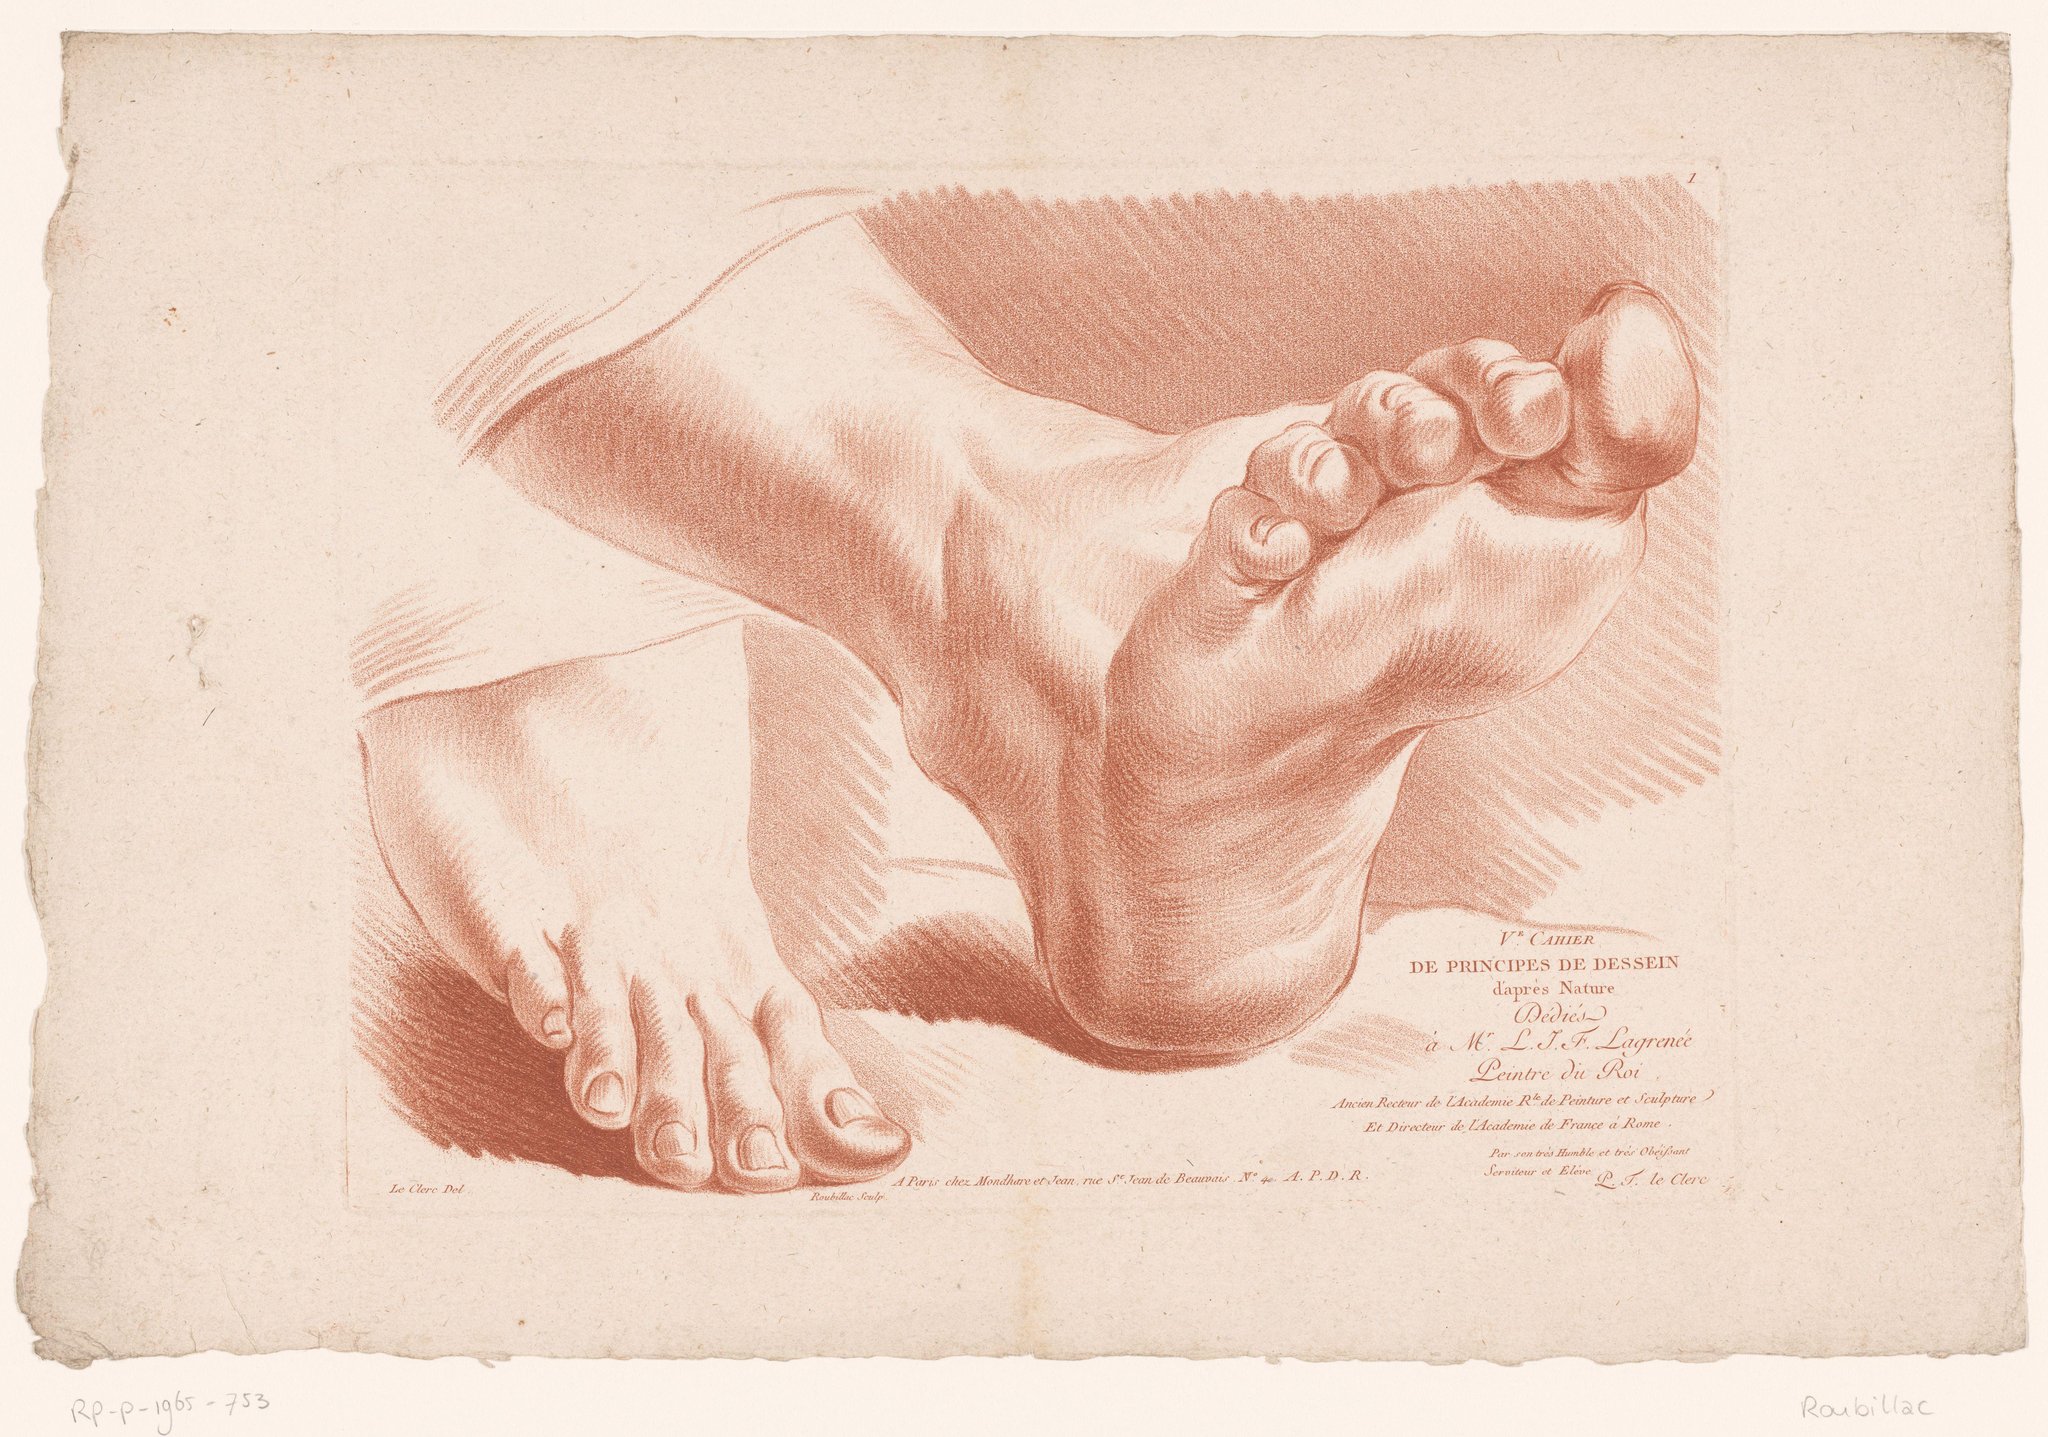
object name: print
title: Titelprent met twee voeten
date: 1784-1796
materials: paper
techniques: printmaking, etching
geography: france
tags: drawing, sketch, foot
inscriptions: collector's mark: Lugt 2228